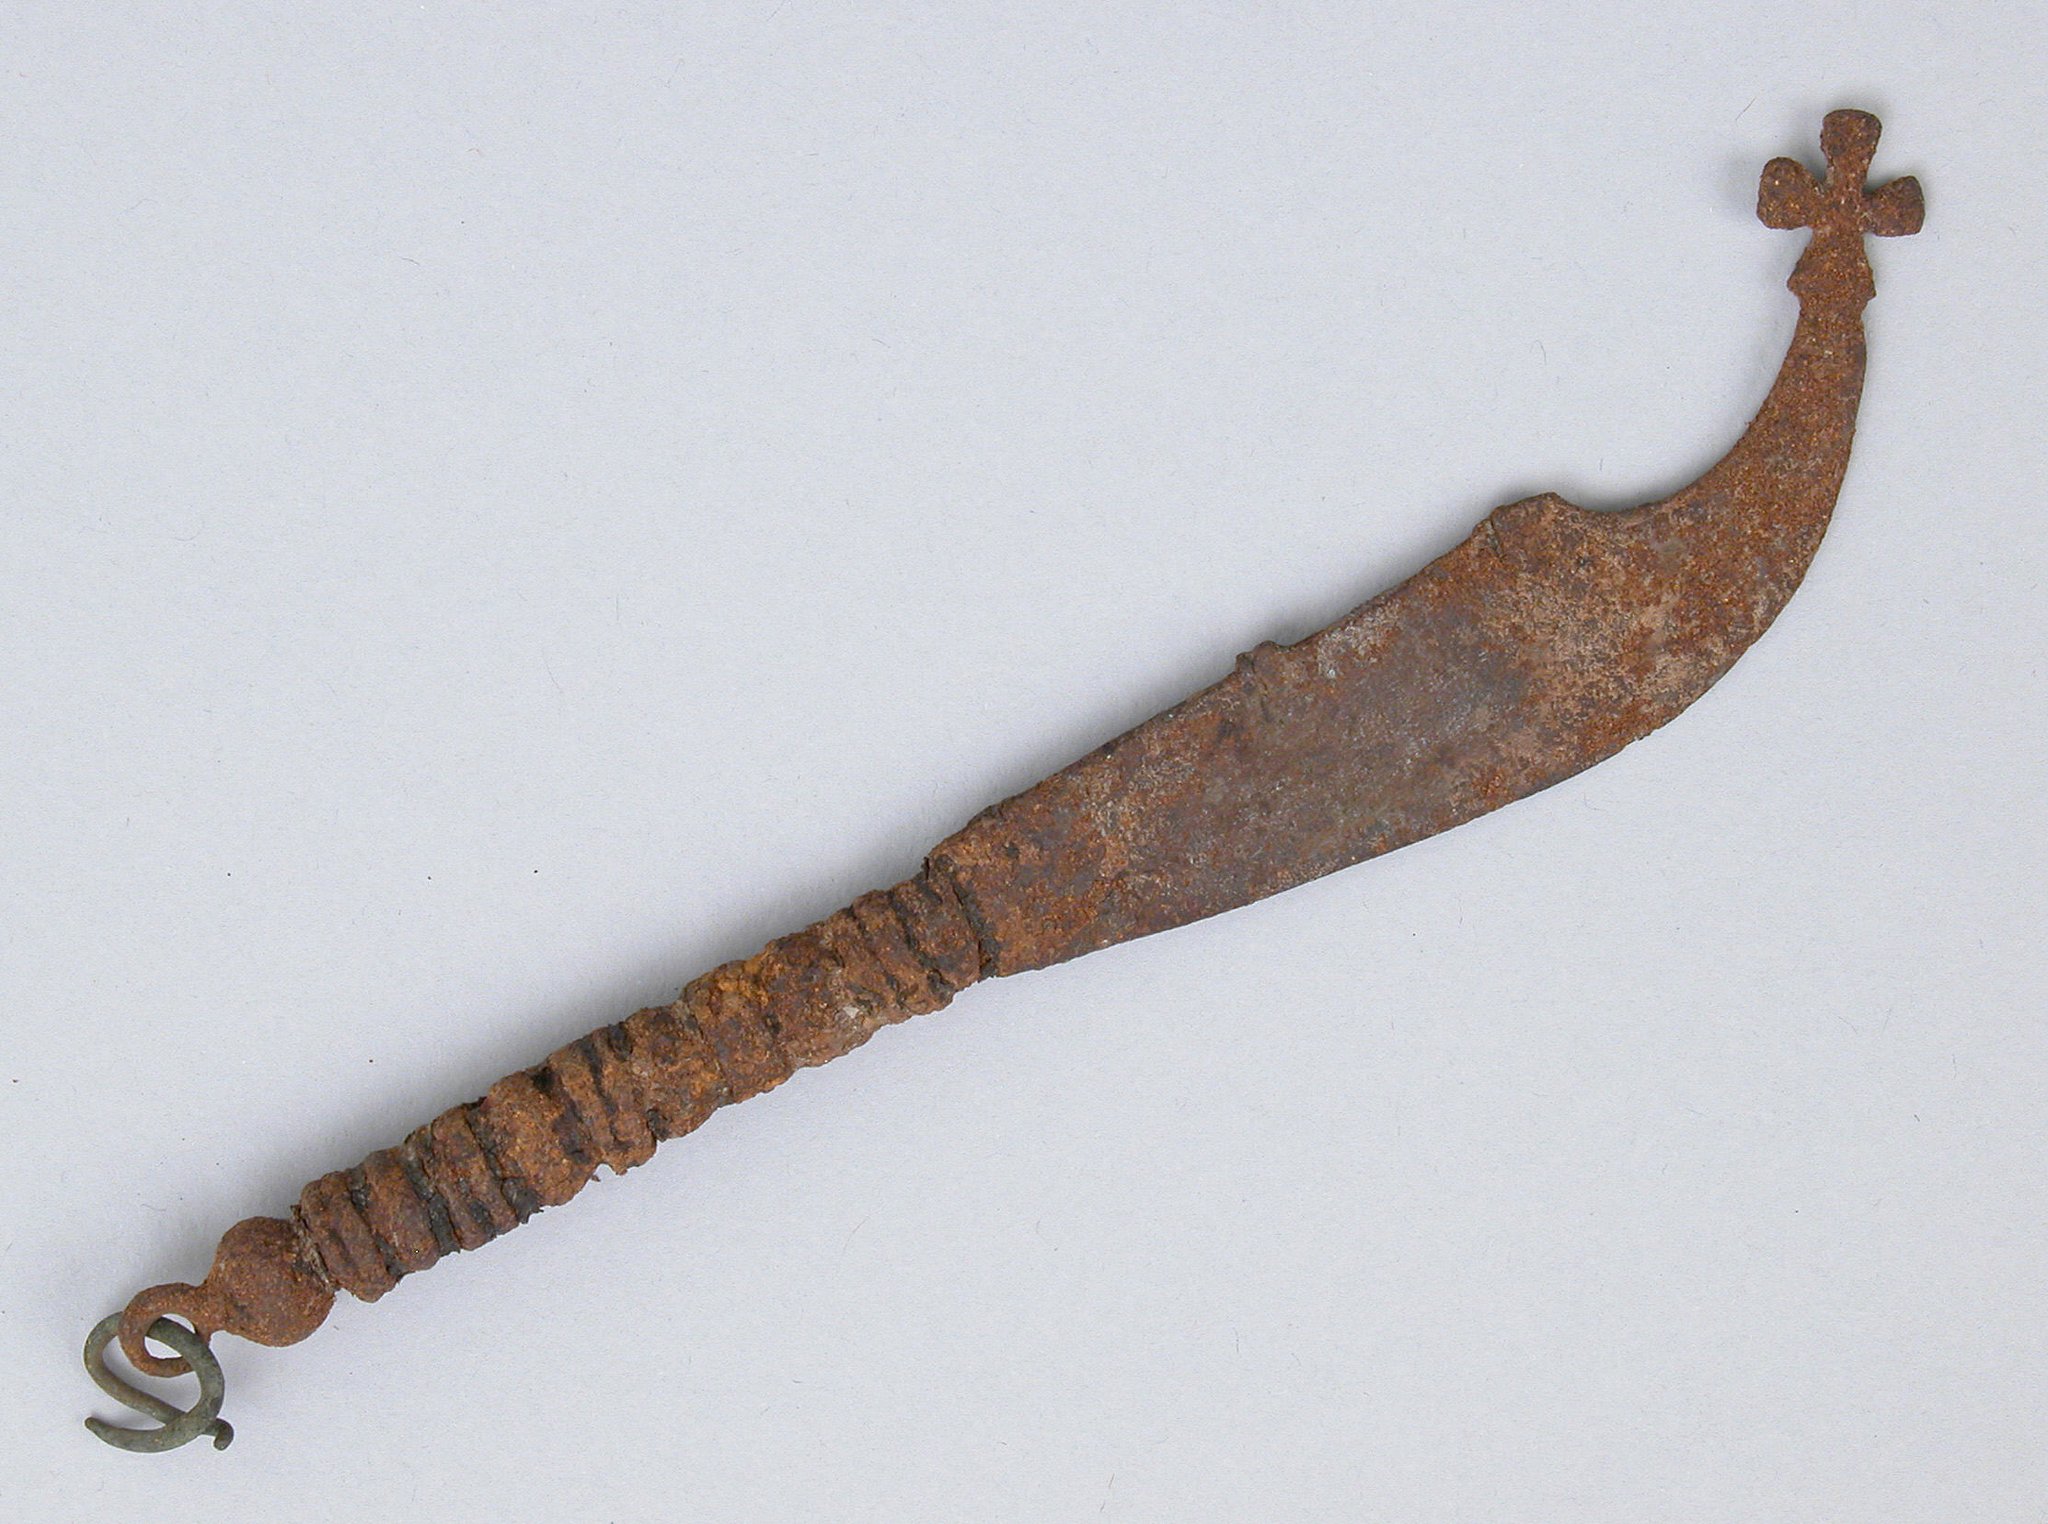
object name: knife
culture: coptic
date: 580-640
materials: iron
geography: egypt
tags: knives